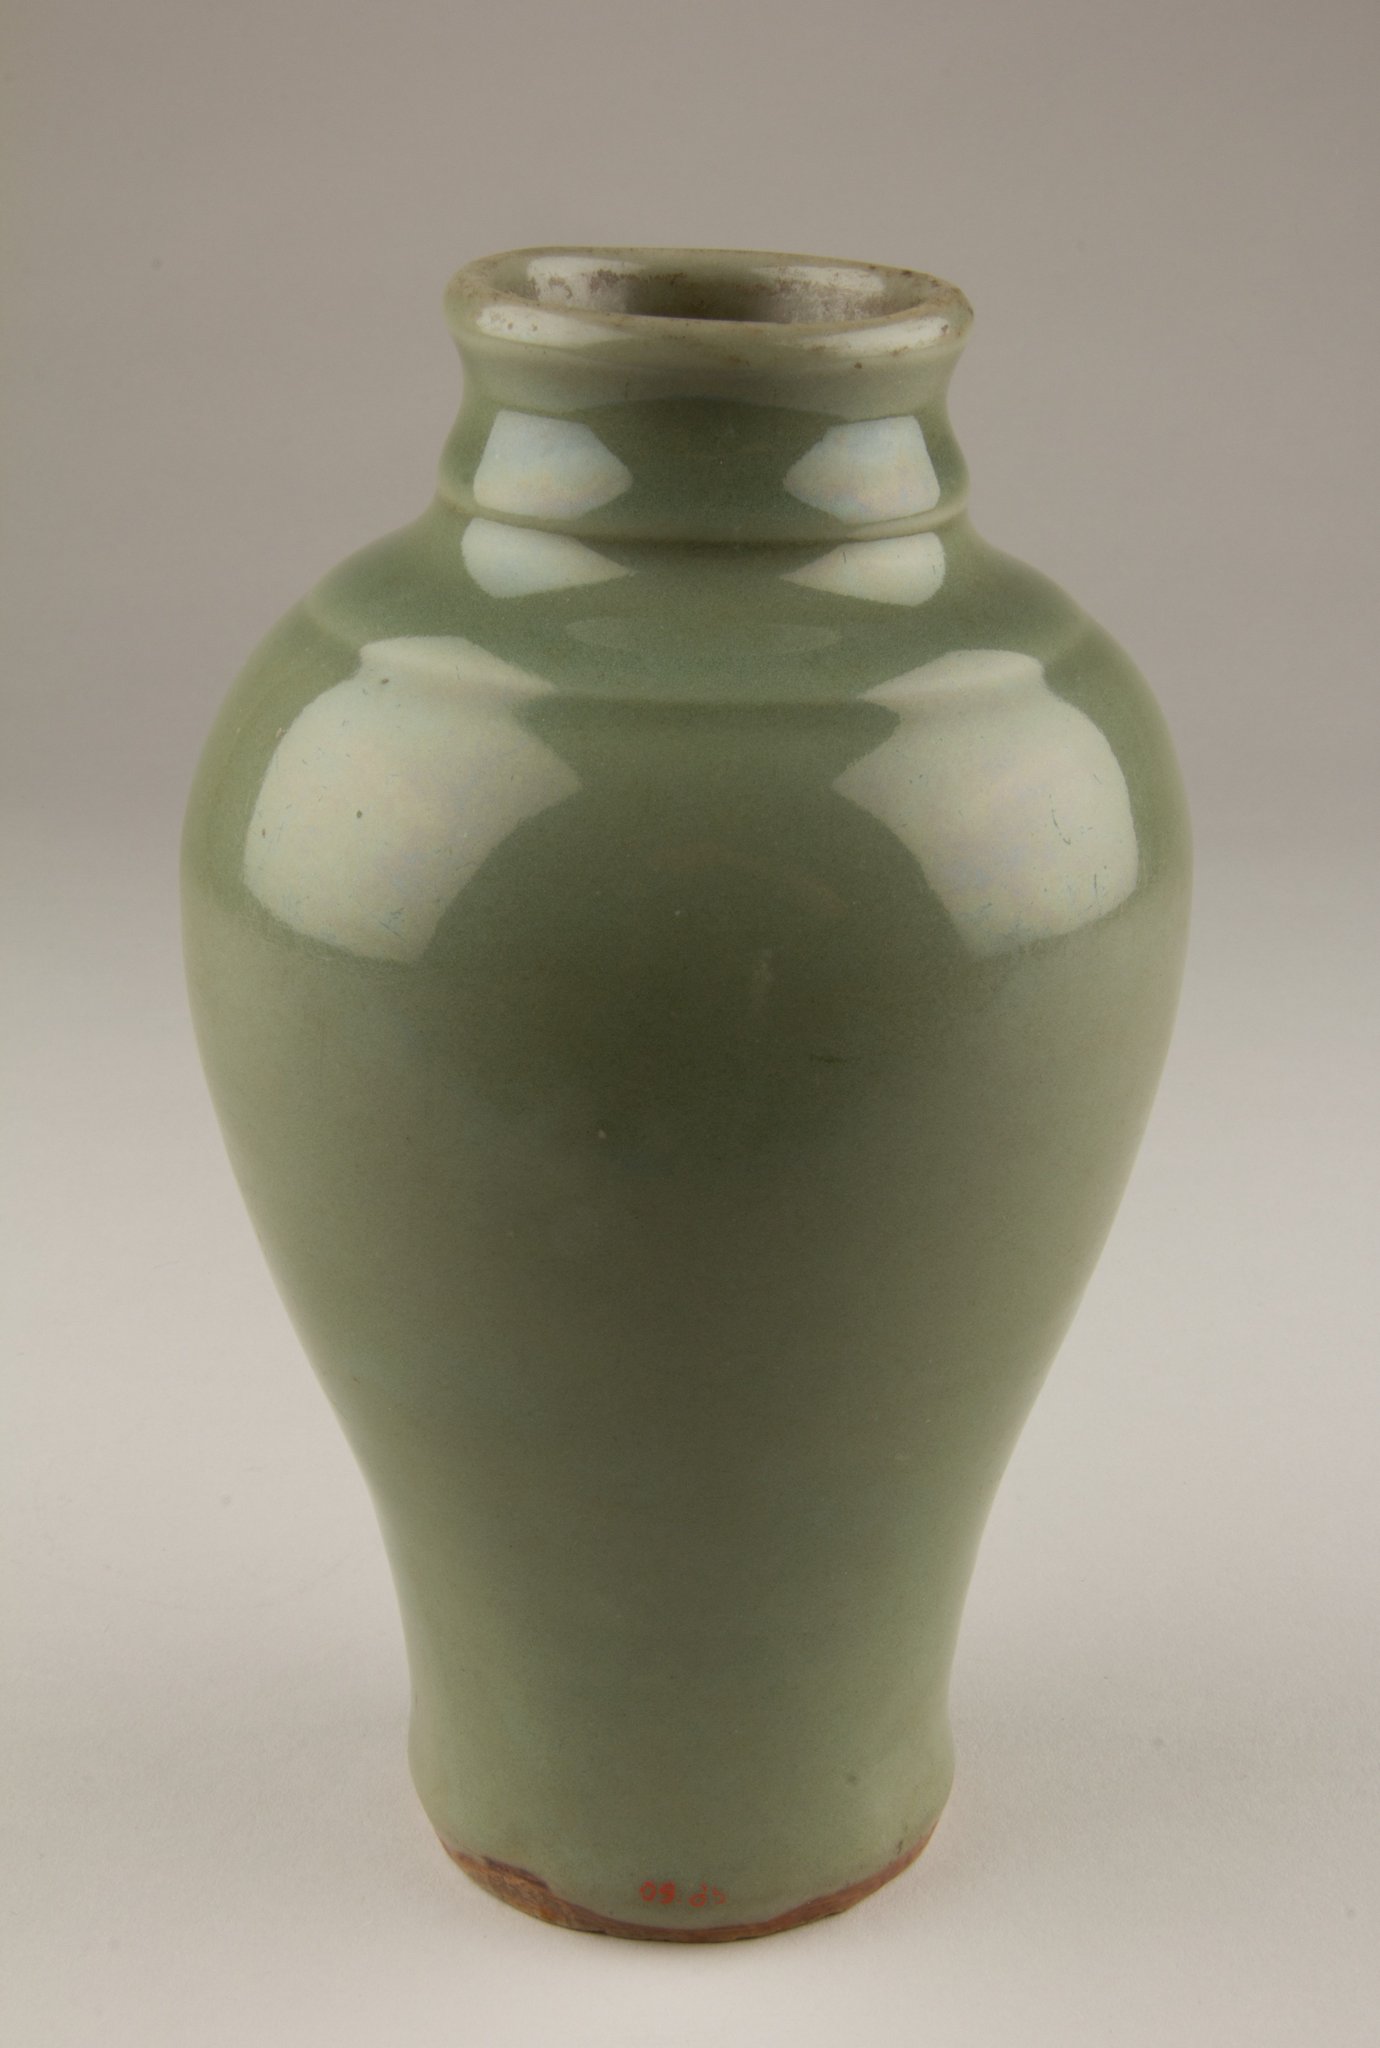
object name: vase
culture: chinese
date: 1801-1900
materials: ceramic glaze, glaze, porcelain